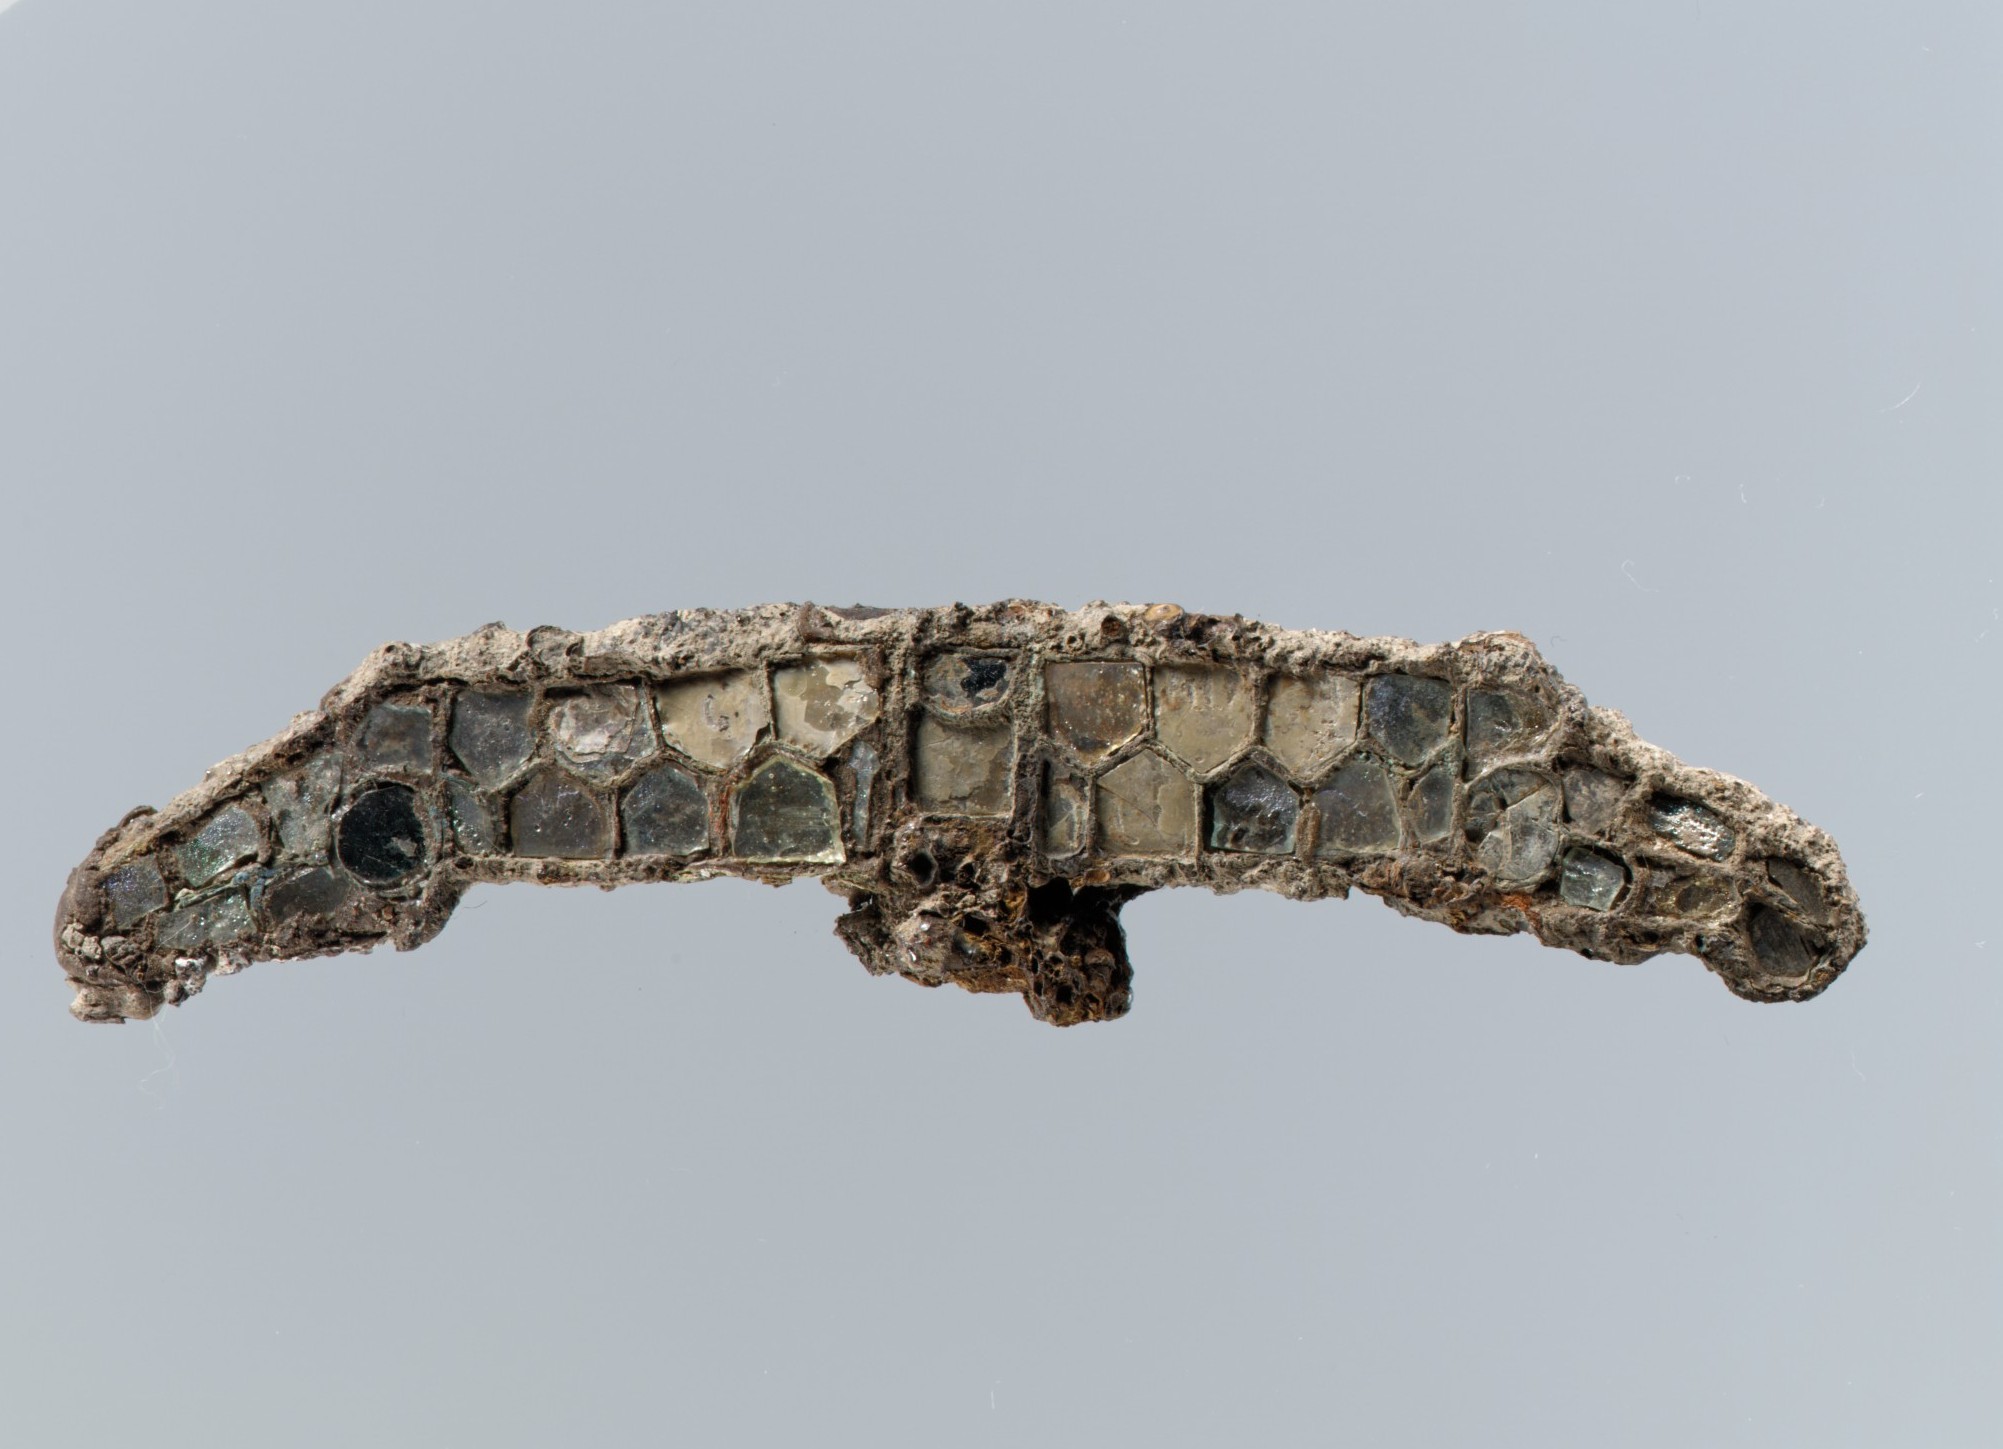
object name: mount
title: Purse Mount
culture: frankish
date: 601-650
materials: copper alloy, glass, silver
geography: northern france